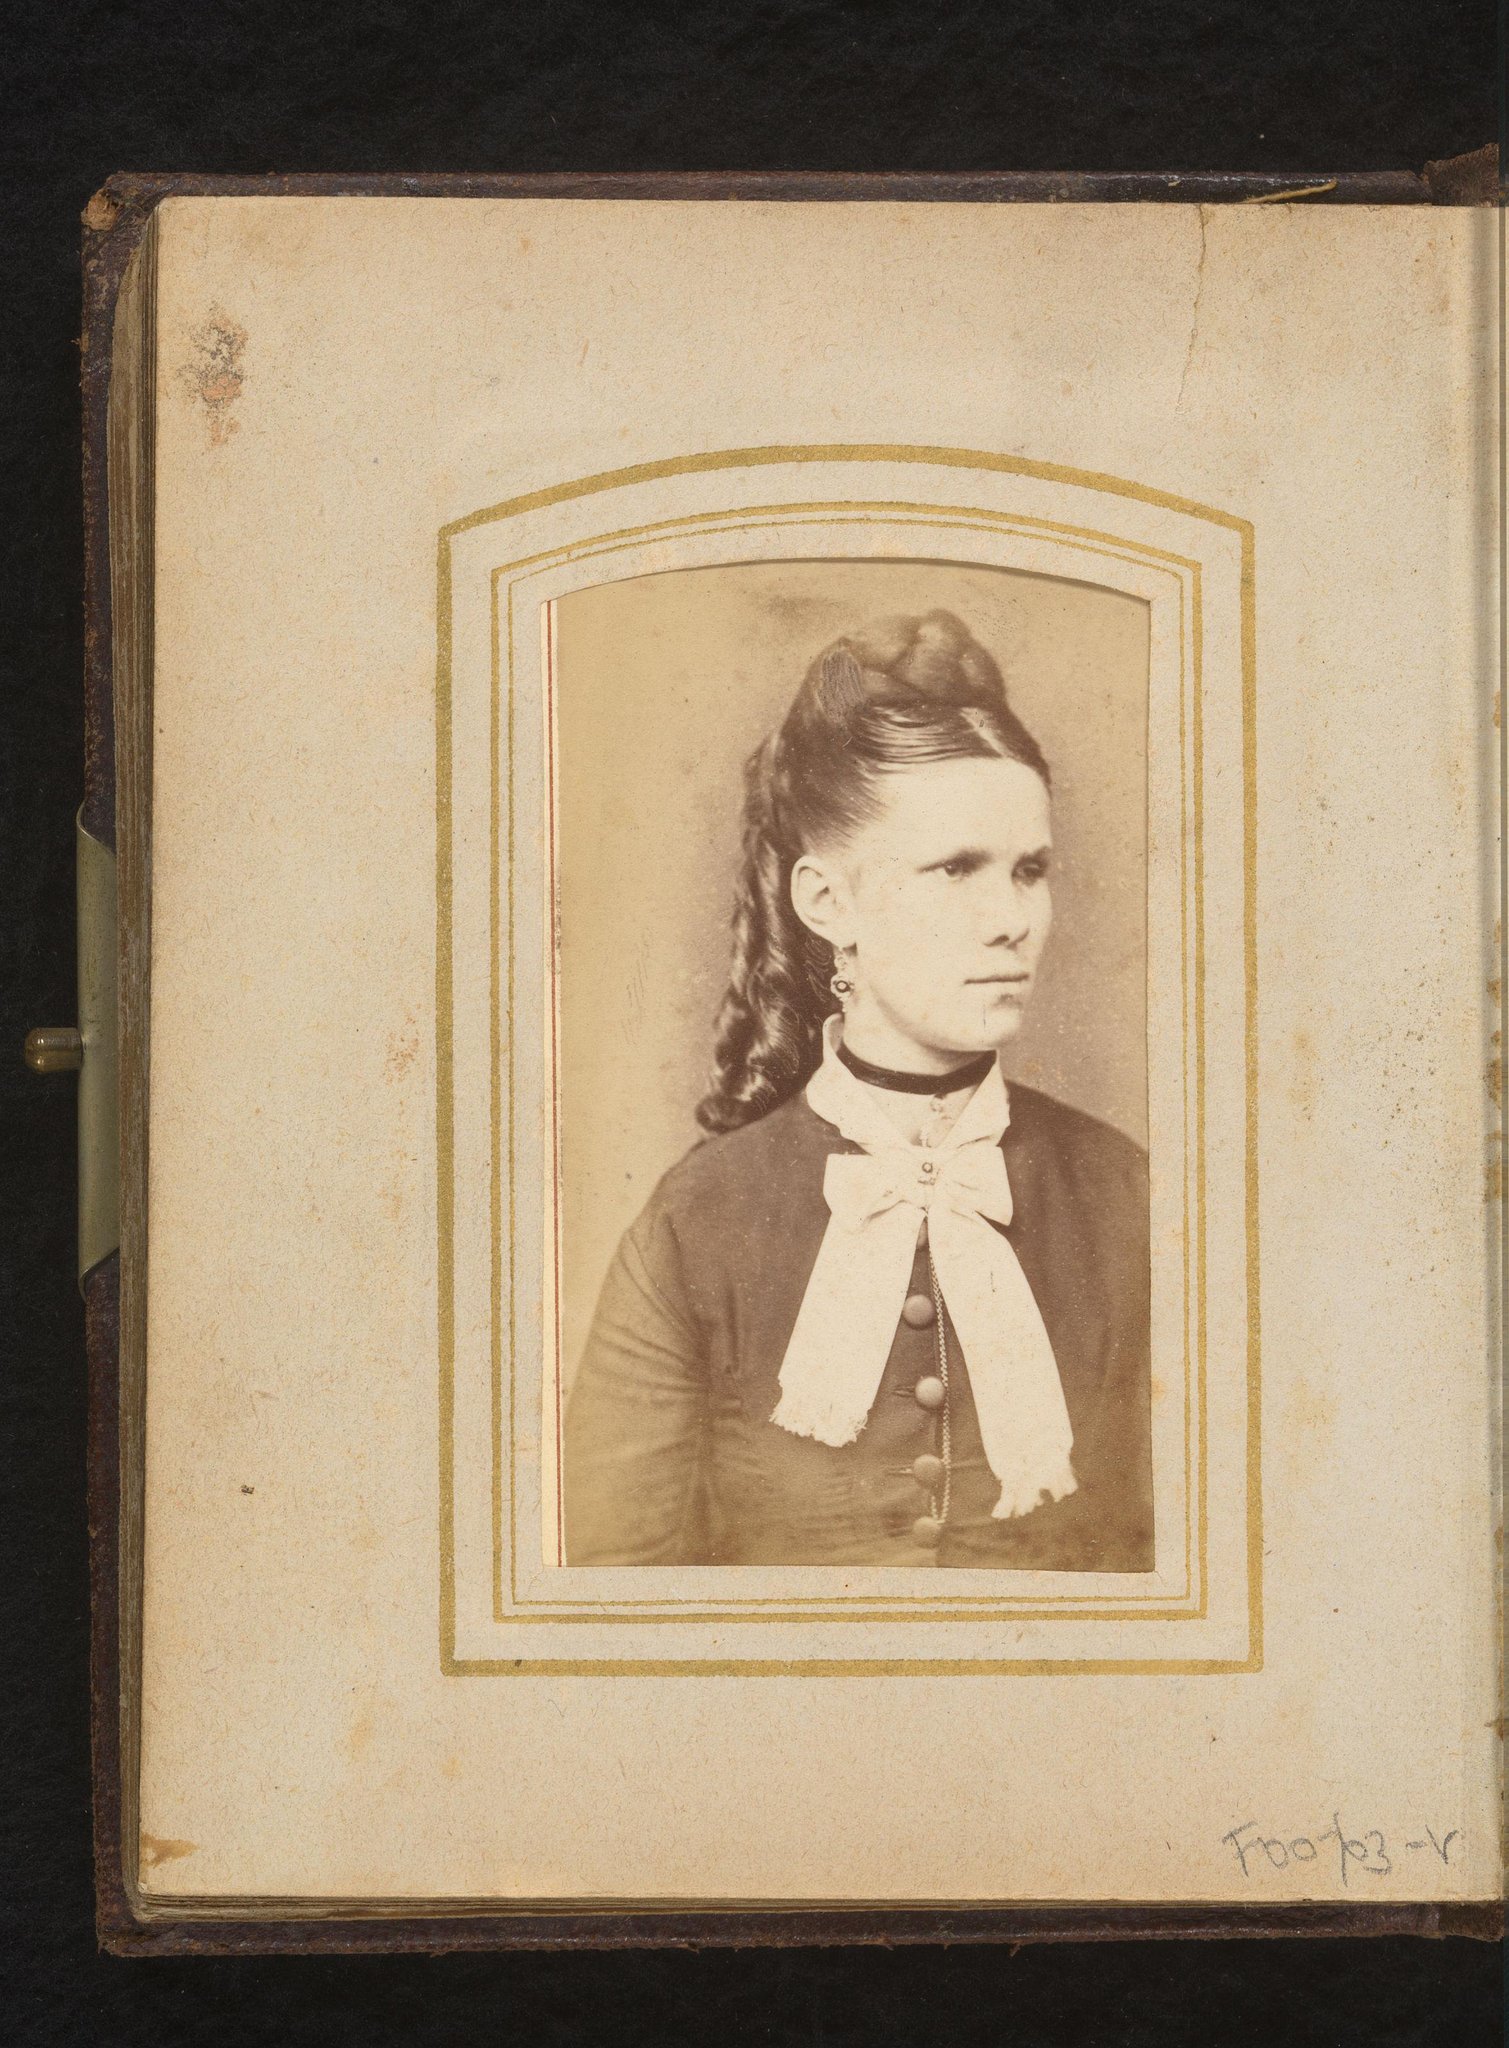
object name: carte de visite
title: Portret van een vrouw met halsketting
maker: johannes wilhelmus karsses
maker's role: draughtsman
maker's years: 1841-1875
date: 1856-1875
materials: cardboard, photographic support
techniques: albumen print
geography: groningen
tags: historical persons - bb - woman, necklace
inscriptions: inscription: ‘J. W. KARSSES/ Kunstschilder en Photograaf/ Buiten [d]e Heerepoort/ O. Z. Heereweg Y. 513/ Groningen/ Voor nabestelling blijft deze plaat bewaard.’